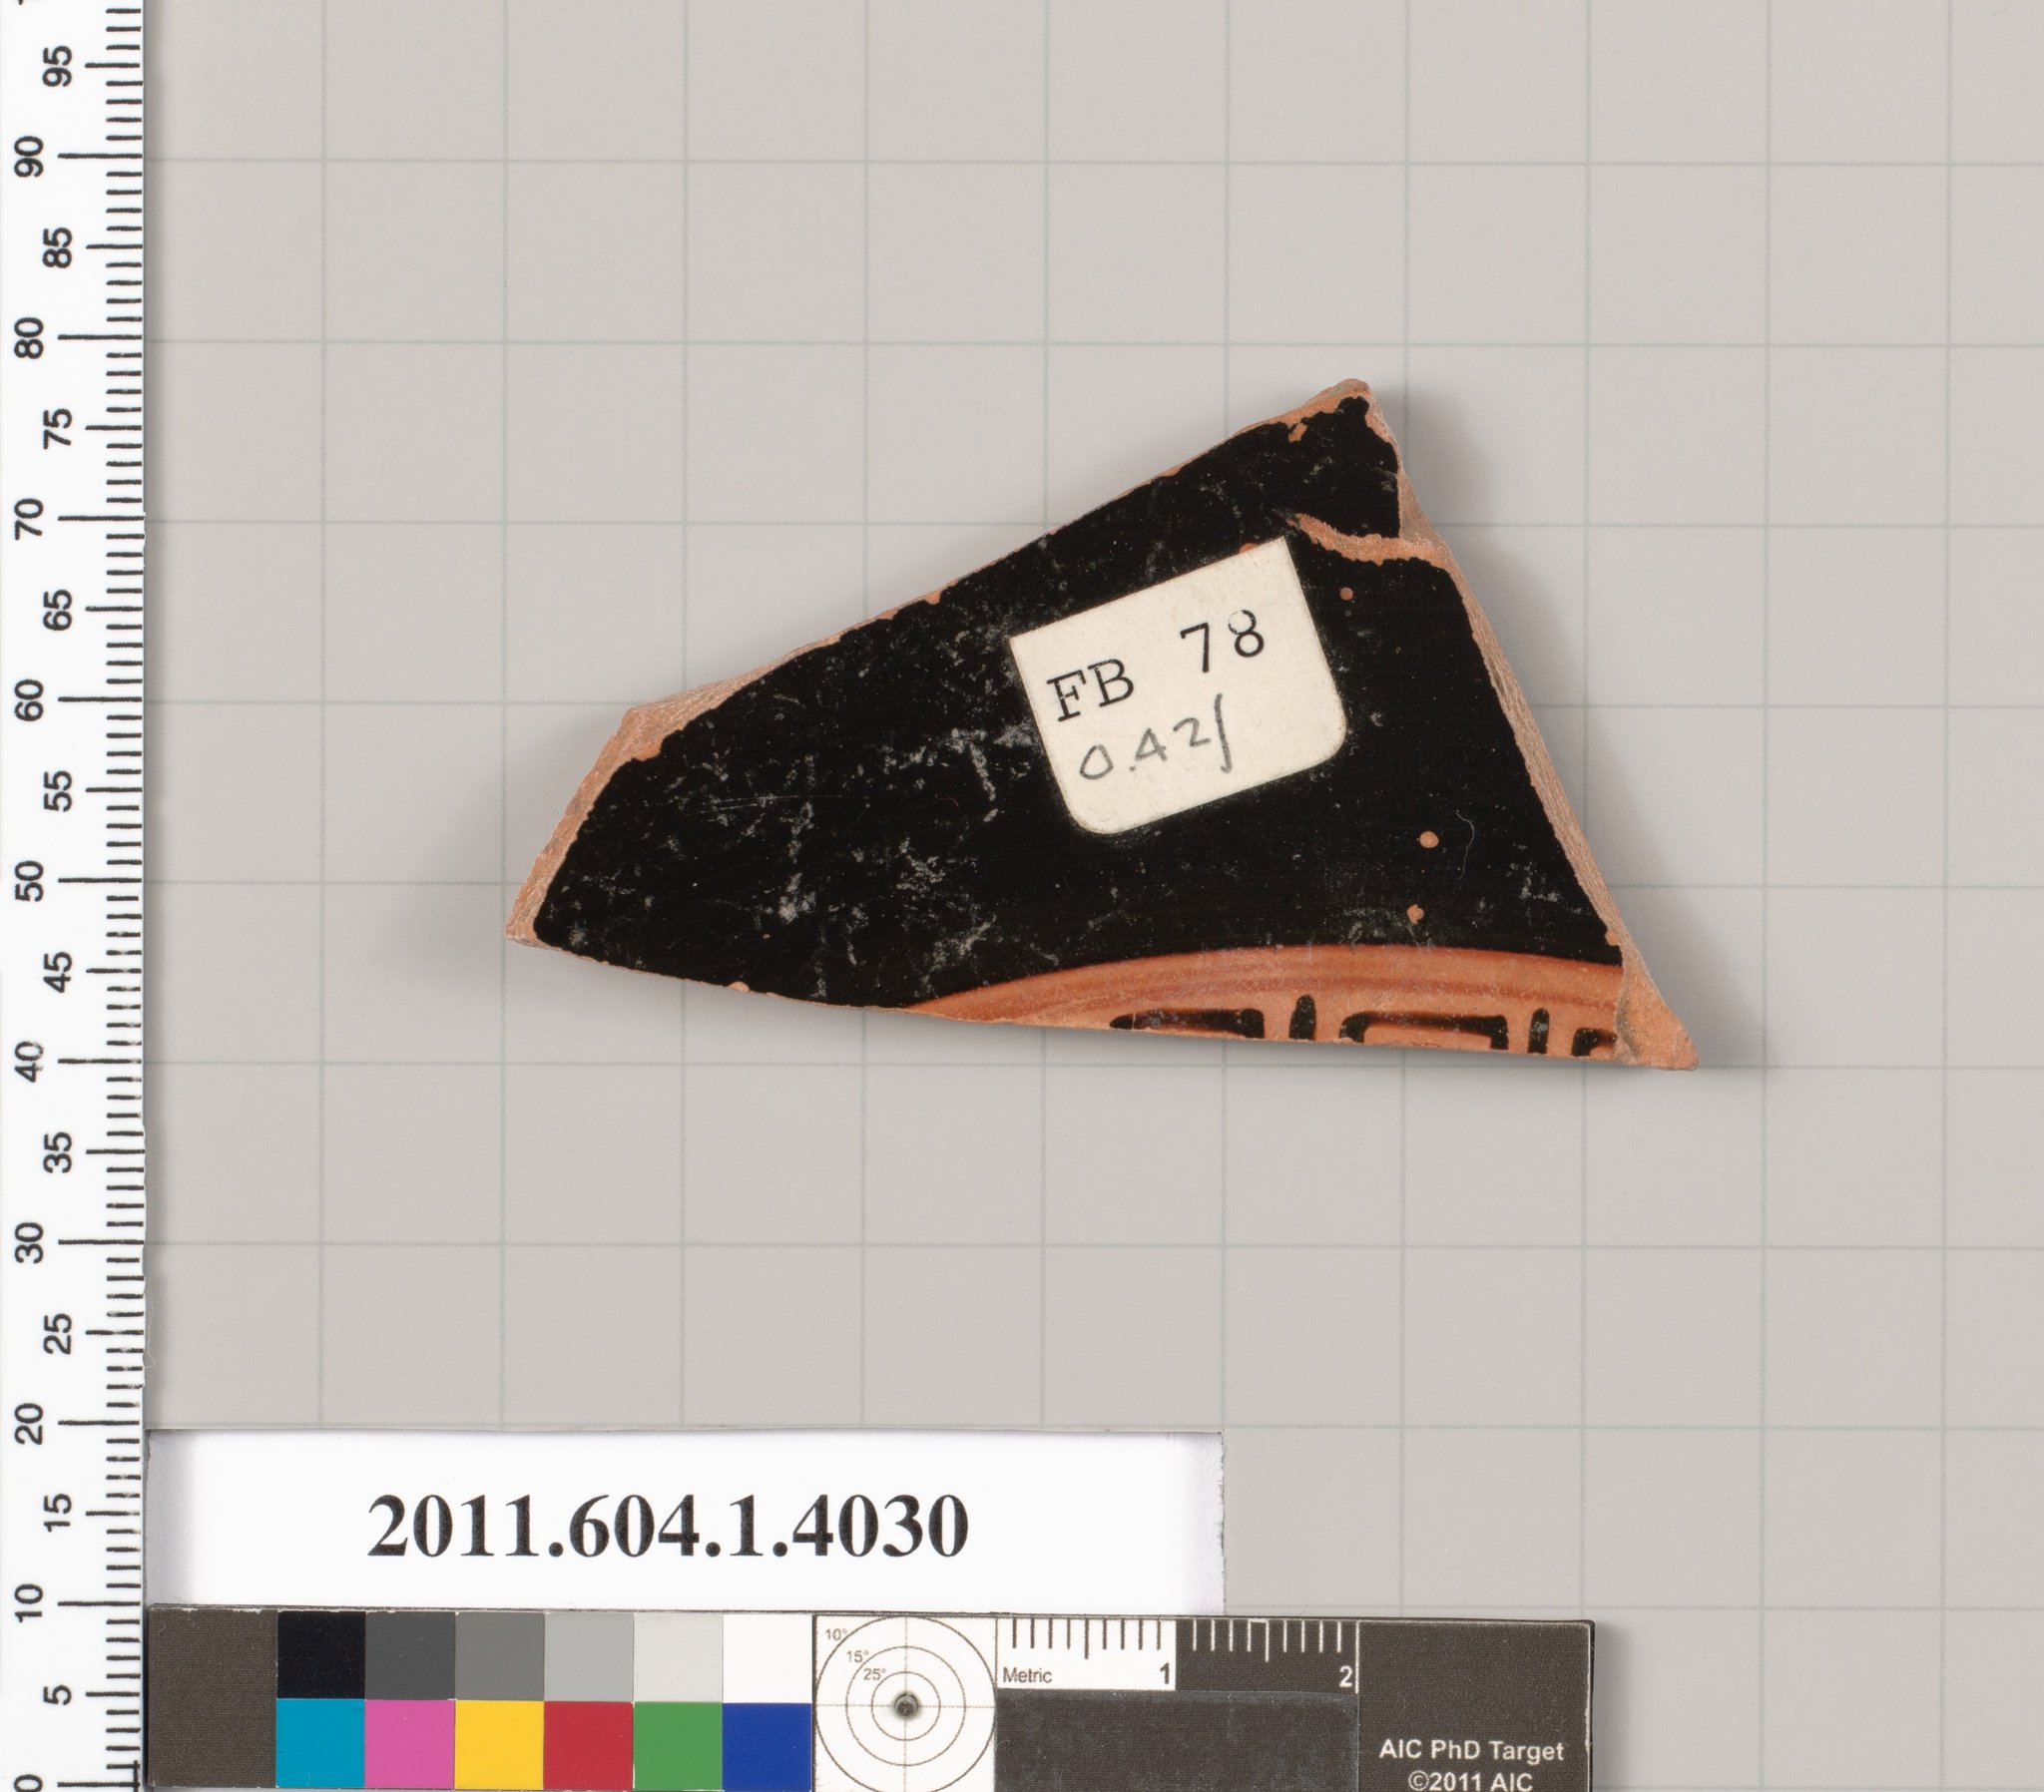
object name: kylix fragment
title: Terracotta fragment of a kylix (drinking cup)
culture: greek, attic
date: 460-440 BCE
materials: terracotta